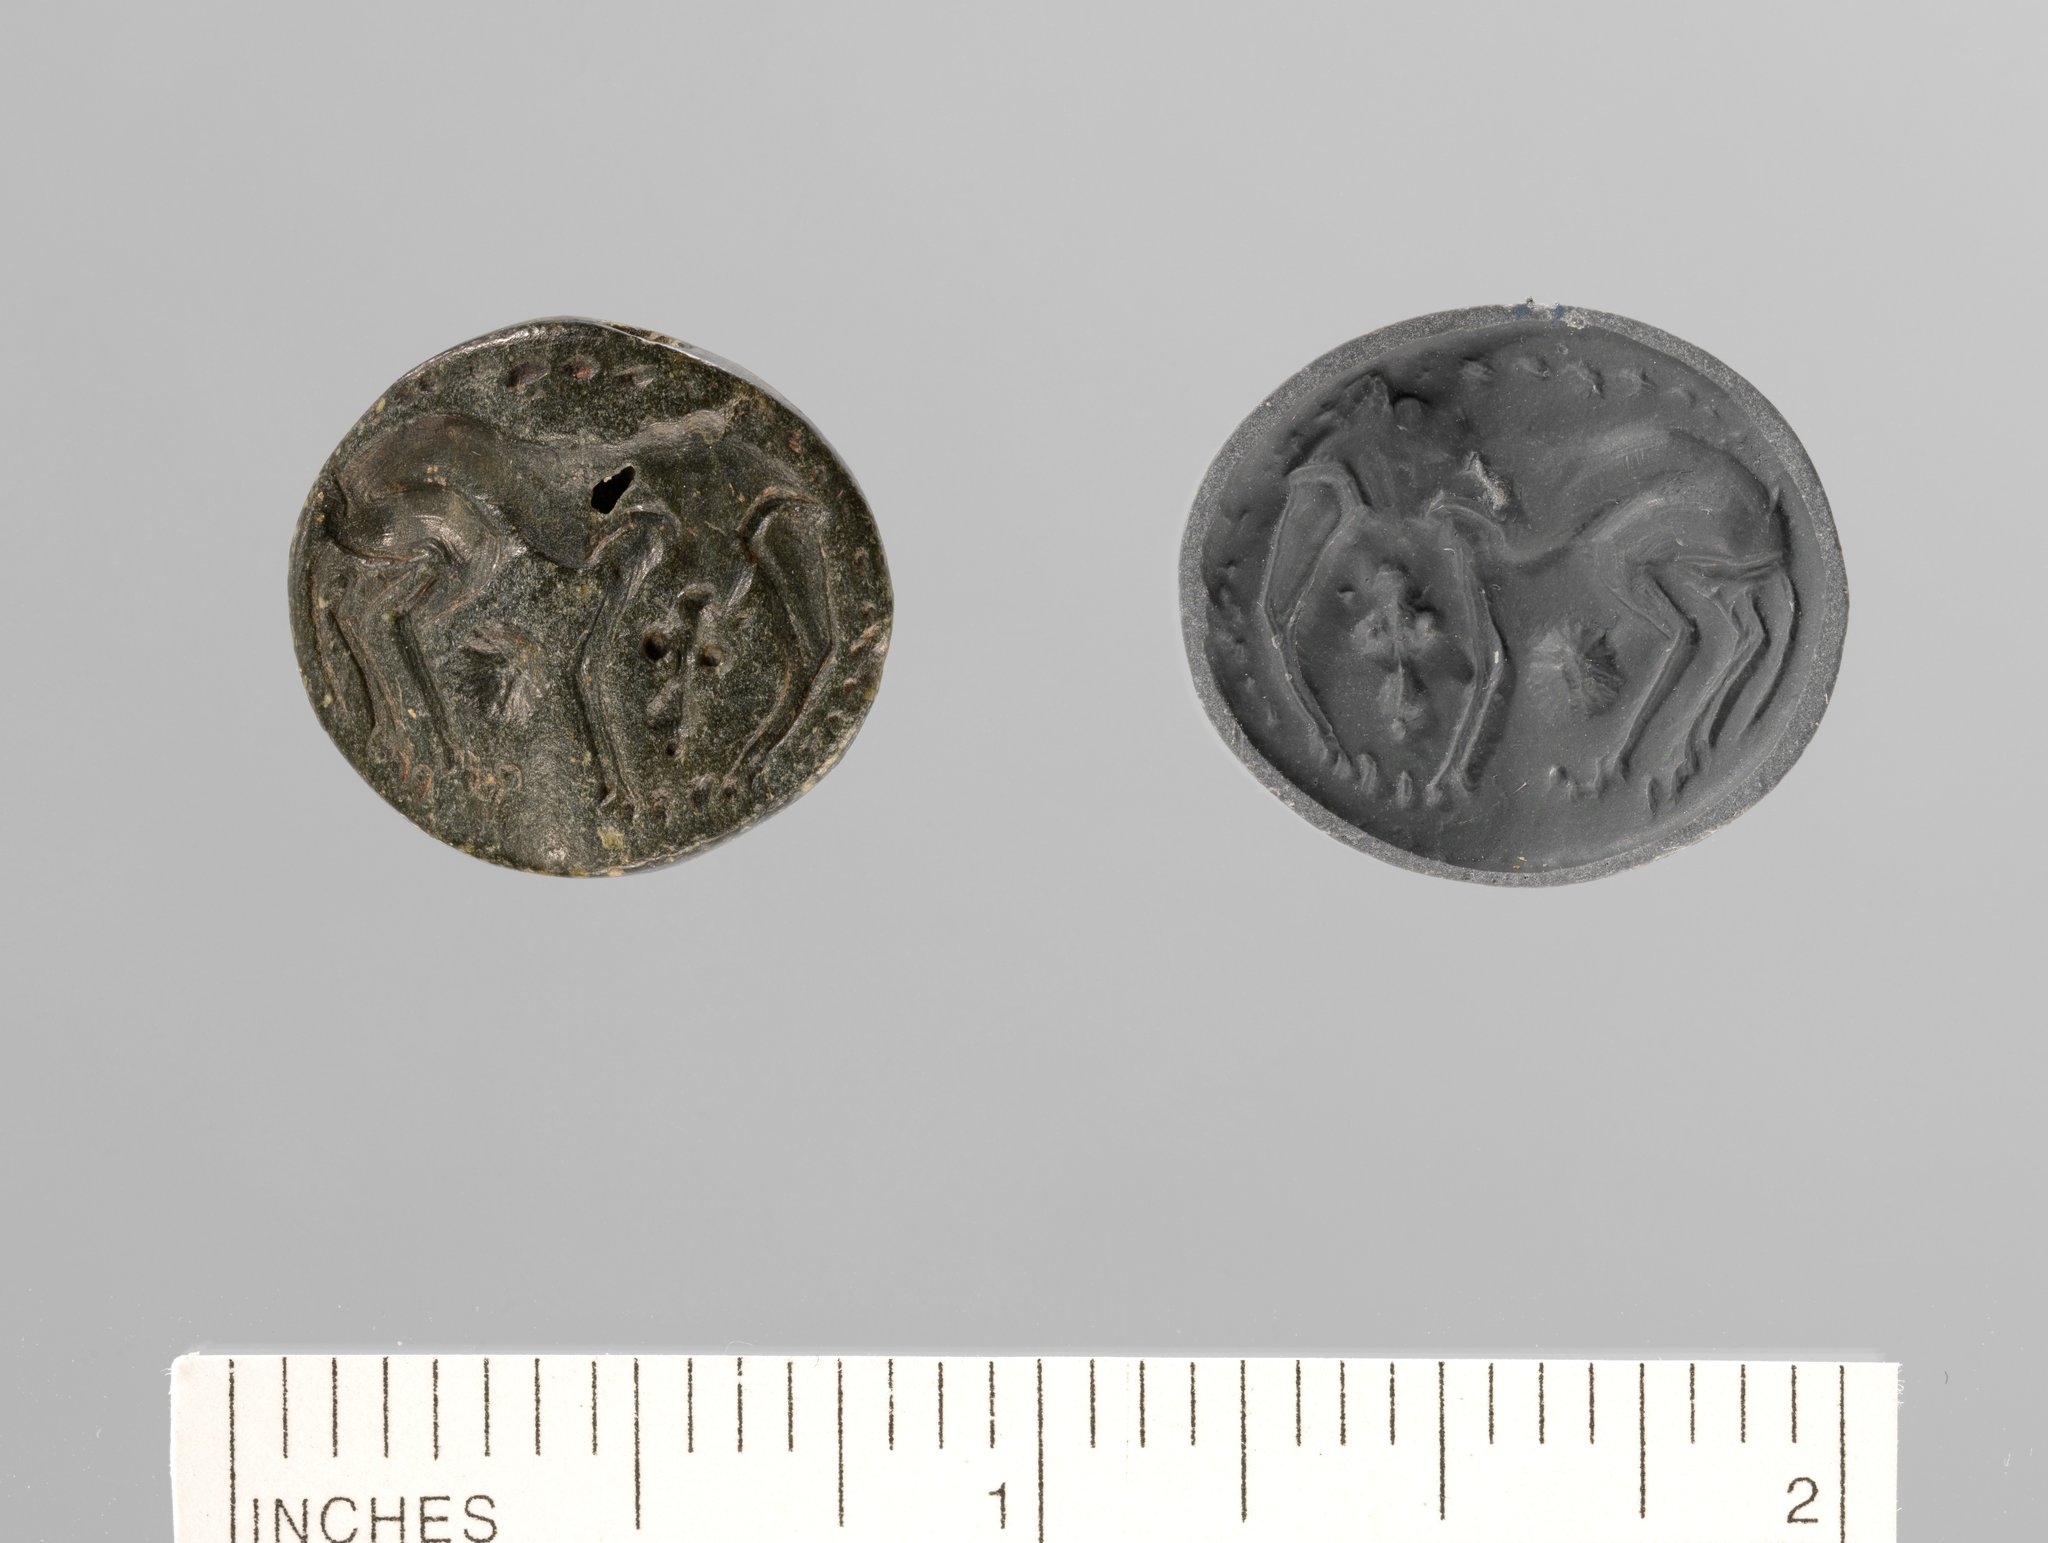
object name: seal, lentoid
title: Steatite Lentoid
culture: minoan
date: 1400-1200 BCE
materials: stone